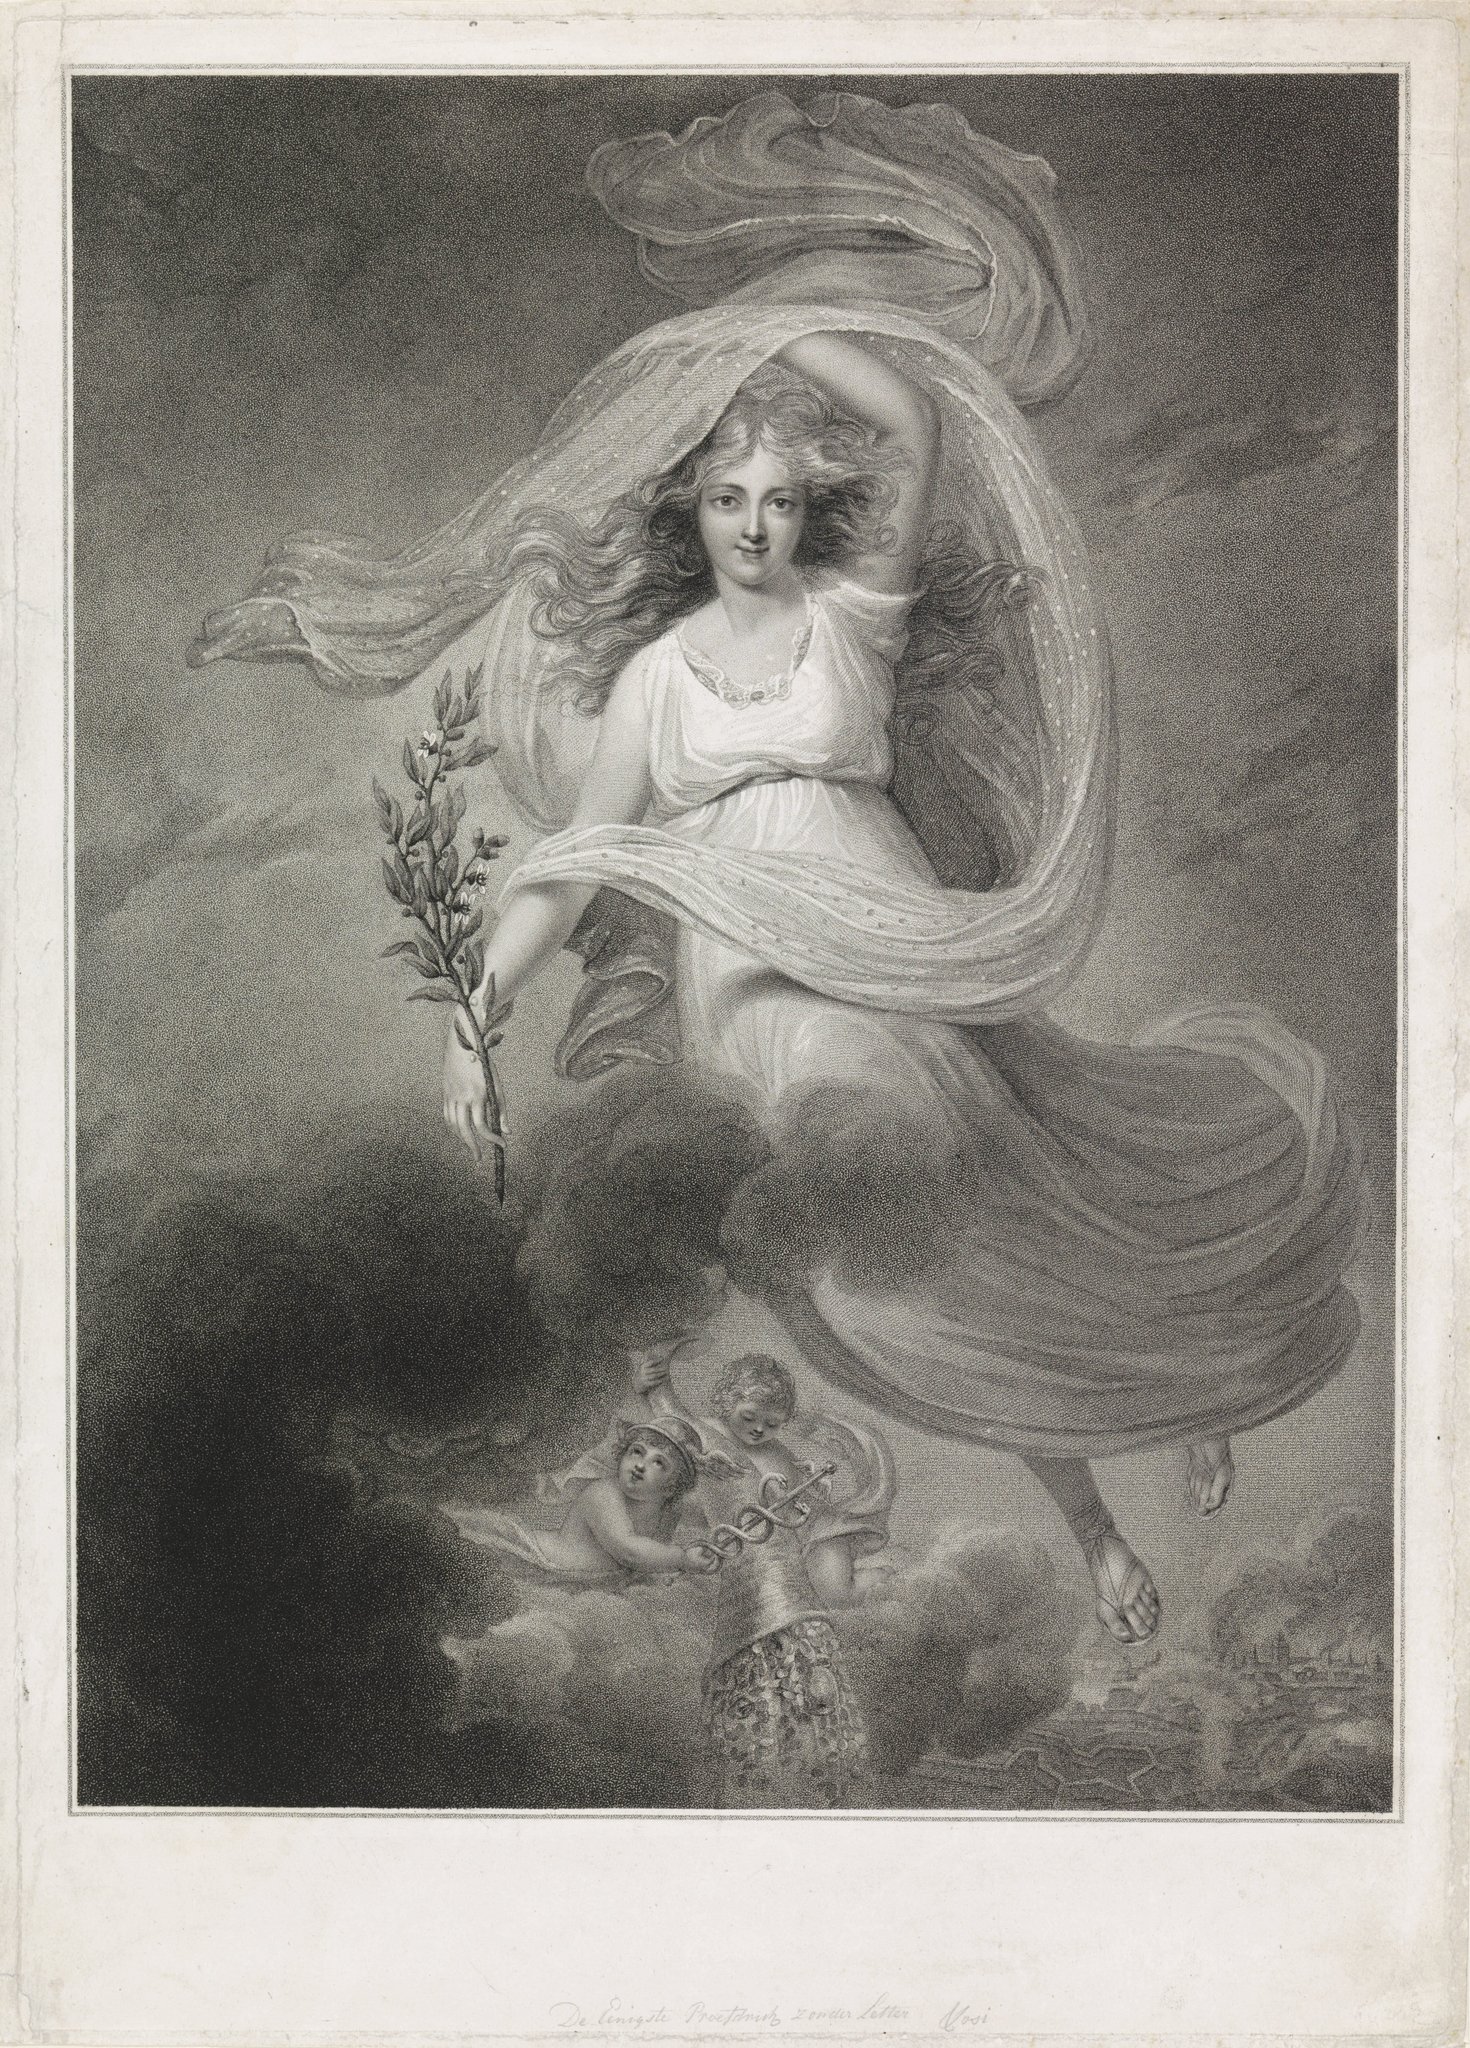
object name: print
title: Allegorie op de Vrede van Amiens, 1802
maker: christiaan josi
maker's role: draughtsman, print maker, publisher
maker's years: 1765-1828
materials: paper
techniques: engraving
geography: london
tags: 'cornucopia', horn of plenty, symbols, allegories of peace, 'pax'; 'pace' (ripa)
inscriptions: inscription: ‘De Eenigste Proefdruk zonder Letter CJosi’, collector's mark: Lugt 2228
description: Allegorie op de Vrede van Amiens, op 27 maart 1802, die een einde maakte aan de oorlog tussen Groot-Brittannië en de Franse republiek, Spanje en de Bataafse Republiek. Centraal zweeft de Vrede door de wolken met een olijftak in de hand. Onderaan twee putti (Koophandel en Overvloed) met een hoorn van overvloed, rechts een stad verwoest door de oorlog.